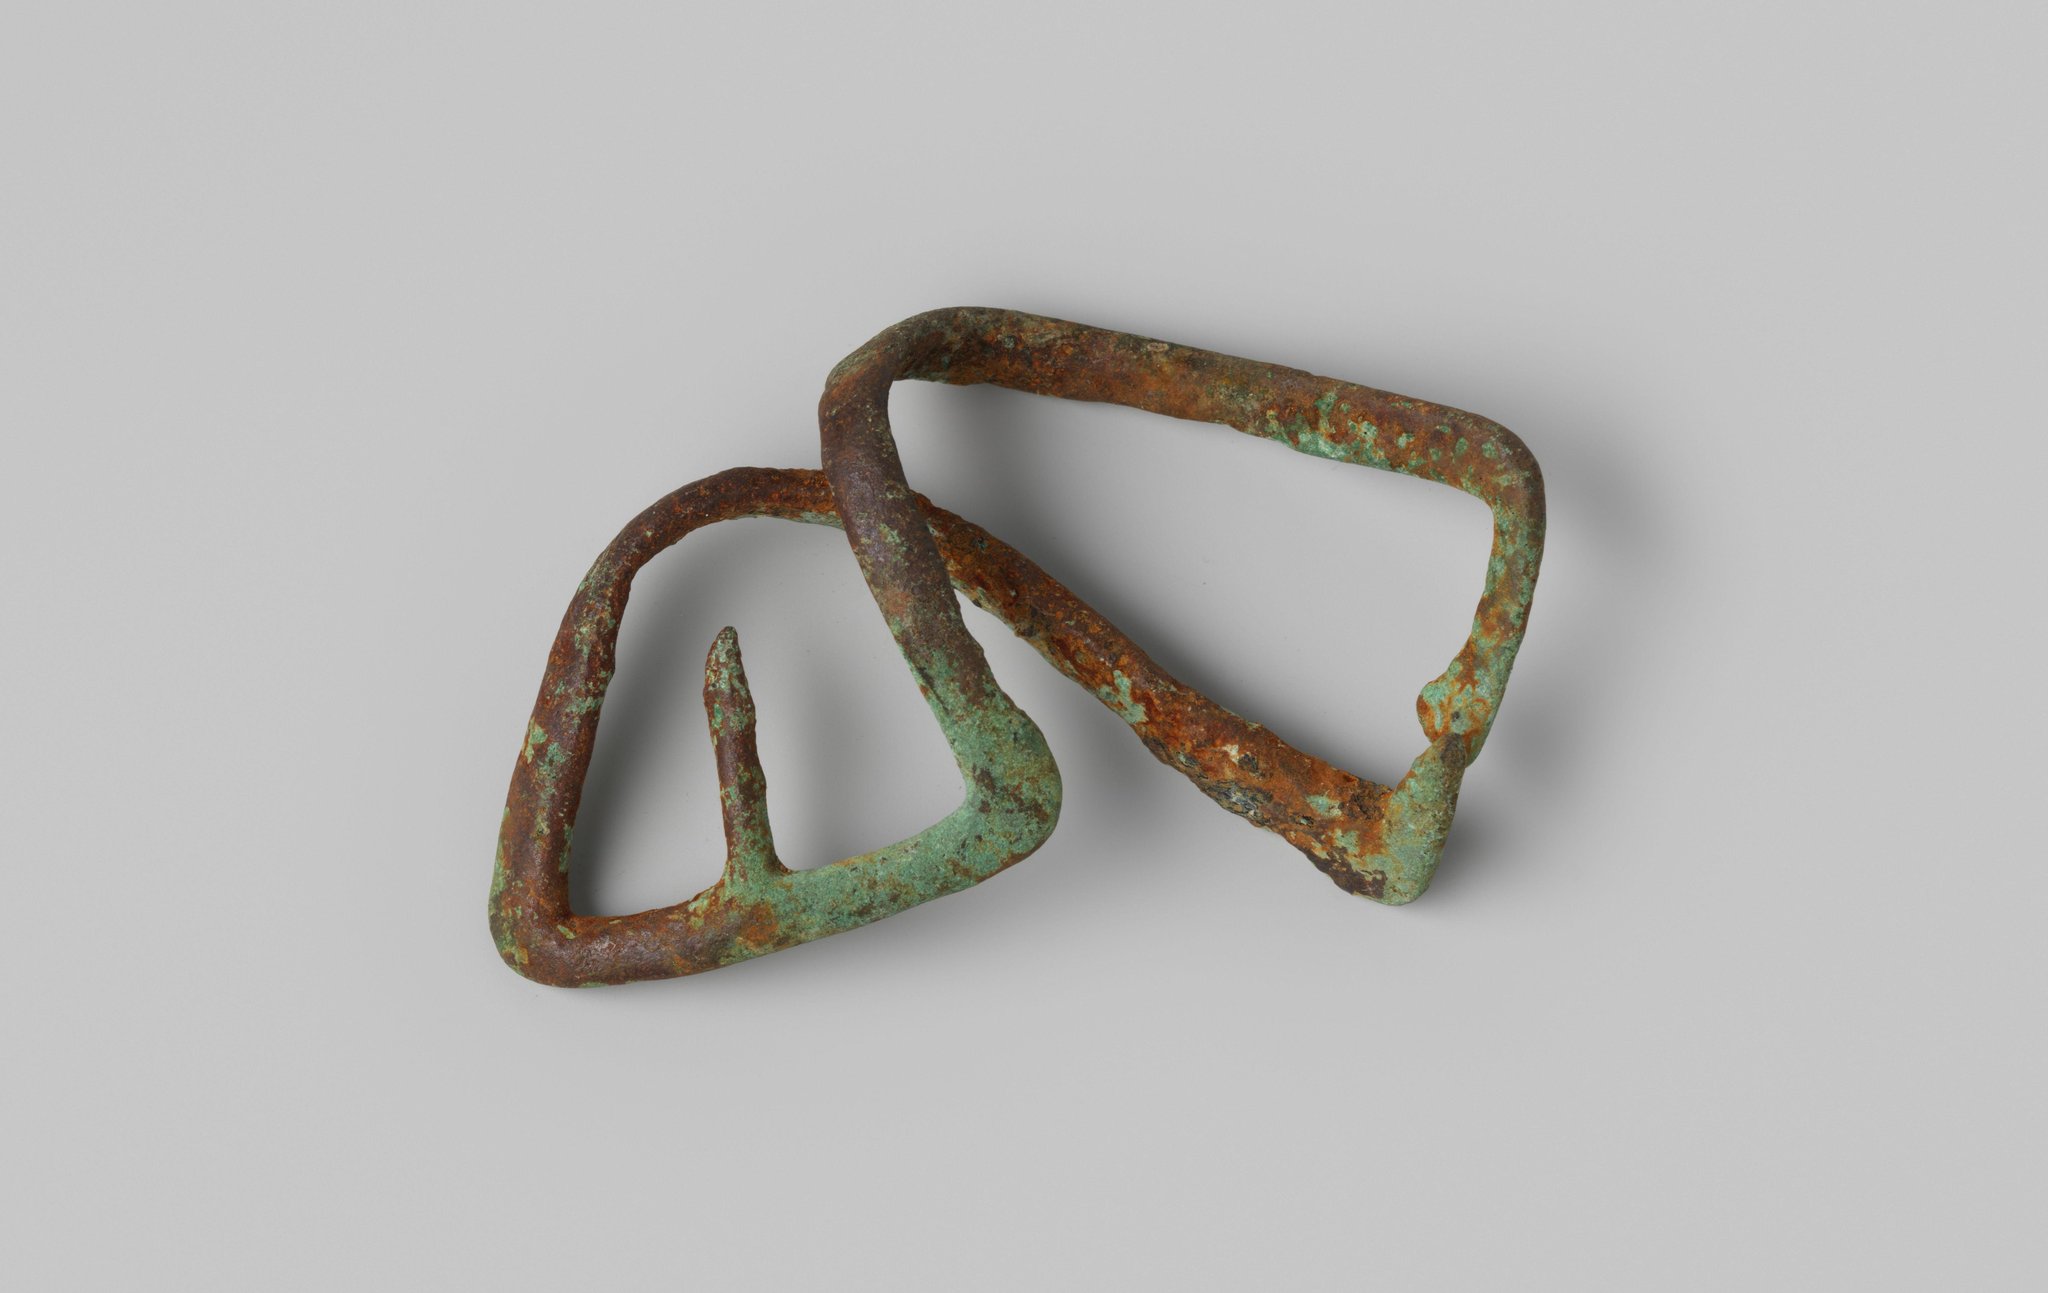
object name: belt buckle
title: Riemgesp uit het wrak van de Oost-Indiëvaarder Hollandia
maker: Anonymous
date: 1700-1743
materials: copper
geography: netherlands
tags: verenigde oostindische compagnie, hollandia (schip), annet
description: Rectangular, ring, bent, id. NG 1980-27H2852, belt buckle.